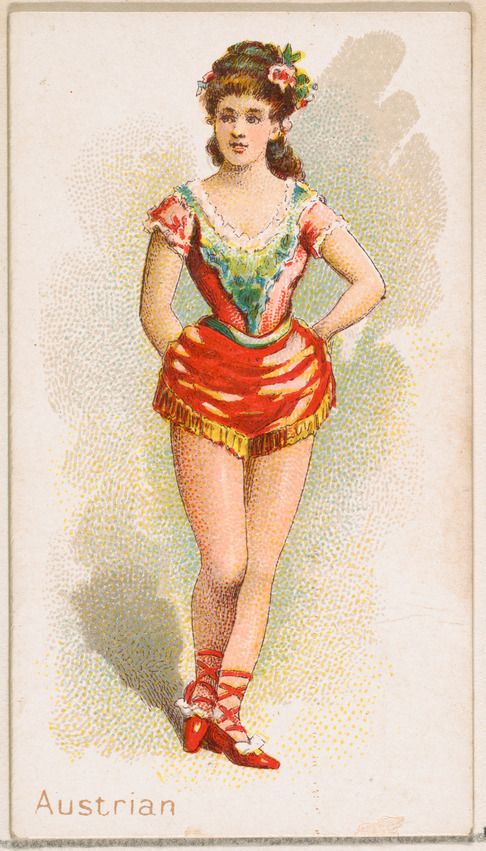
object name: print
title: Austrian Dancer, from the Dancing Women series (N186) issued by Wm. S. Kimball & Co.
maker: william s. kimball & company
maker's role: publisher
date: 1889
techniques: color lithograph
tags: women,dancers